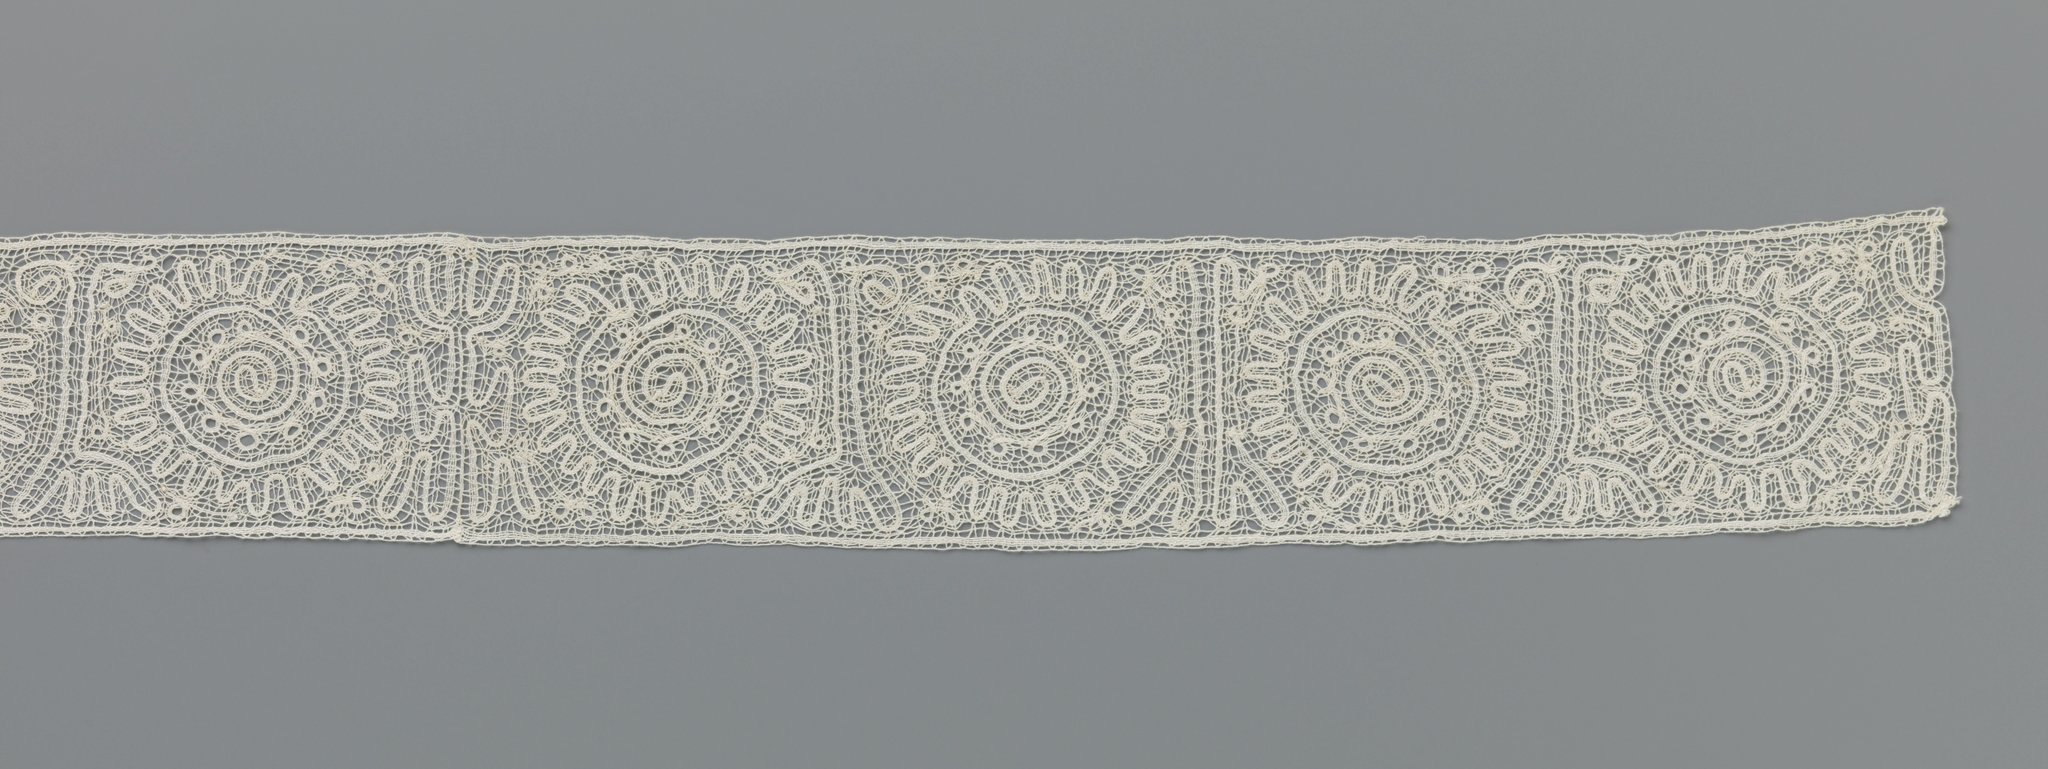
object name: strip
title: Strook kloskant met spiralen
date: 1875-1899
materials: cotton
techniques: lace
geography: eastern europe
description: Strook kloskant van naturelkleurige kloskant, Russische of Oosteuropese kant. Op een grond van onregelmatige vlechten staat een asymmetrisch patroon van grove spiralen van glad lijstwerk, dat door randen van lussen en slingerend lint is vergezeld. Rechte (boom?)-ornamentaties vormen dwarse scheidslijnen tussen de spiralen. De strook is mogelijk bedoeld als tussenzetsel.